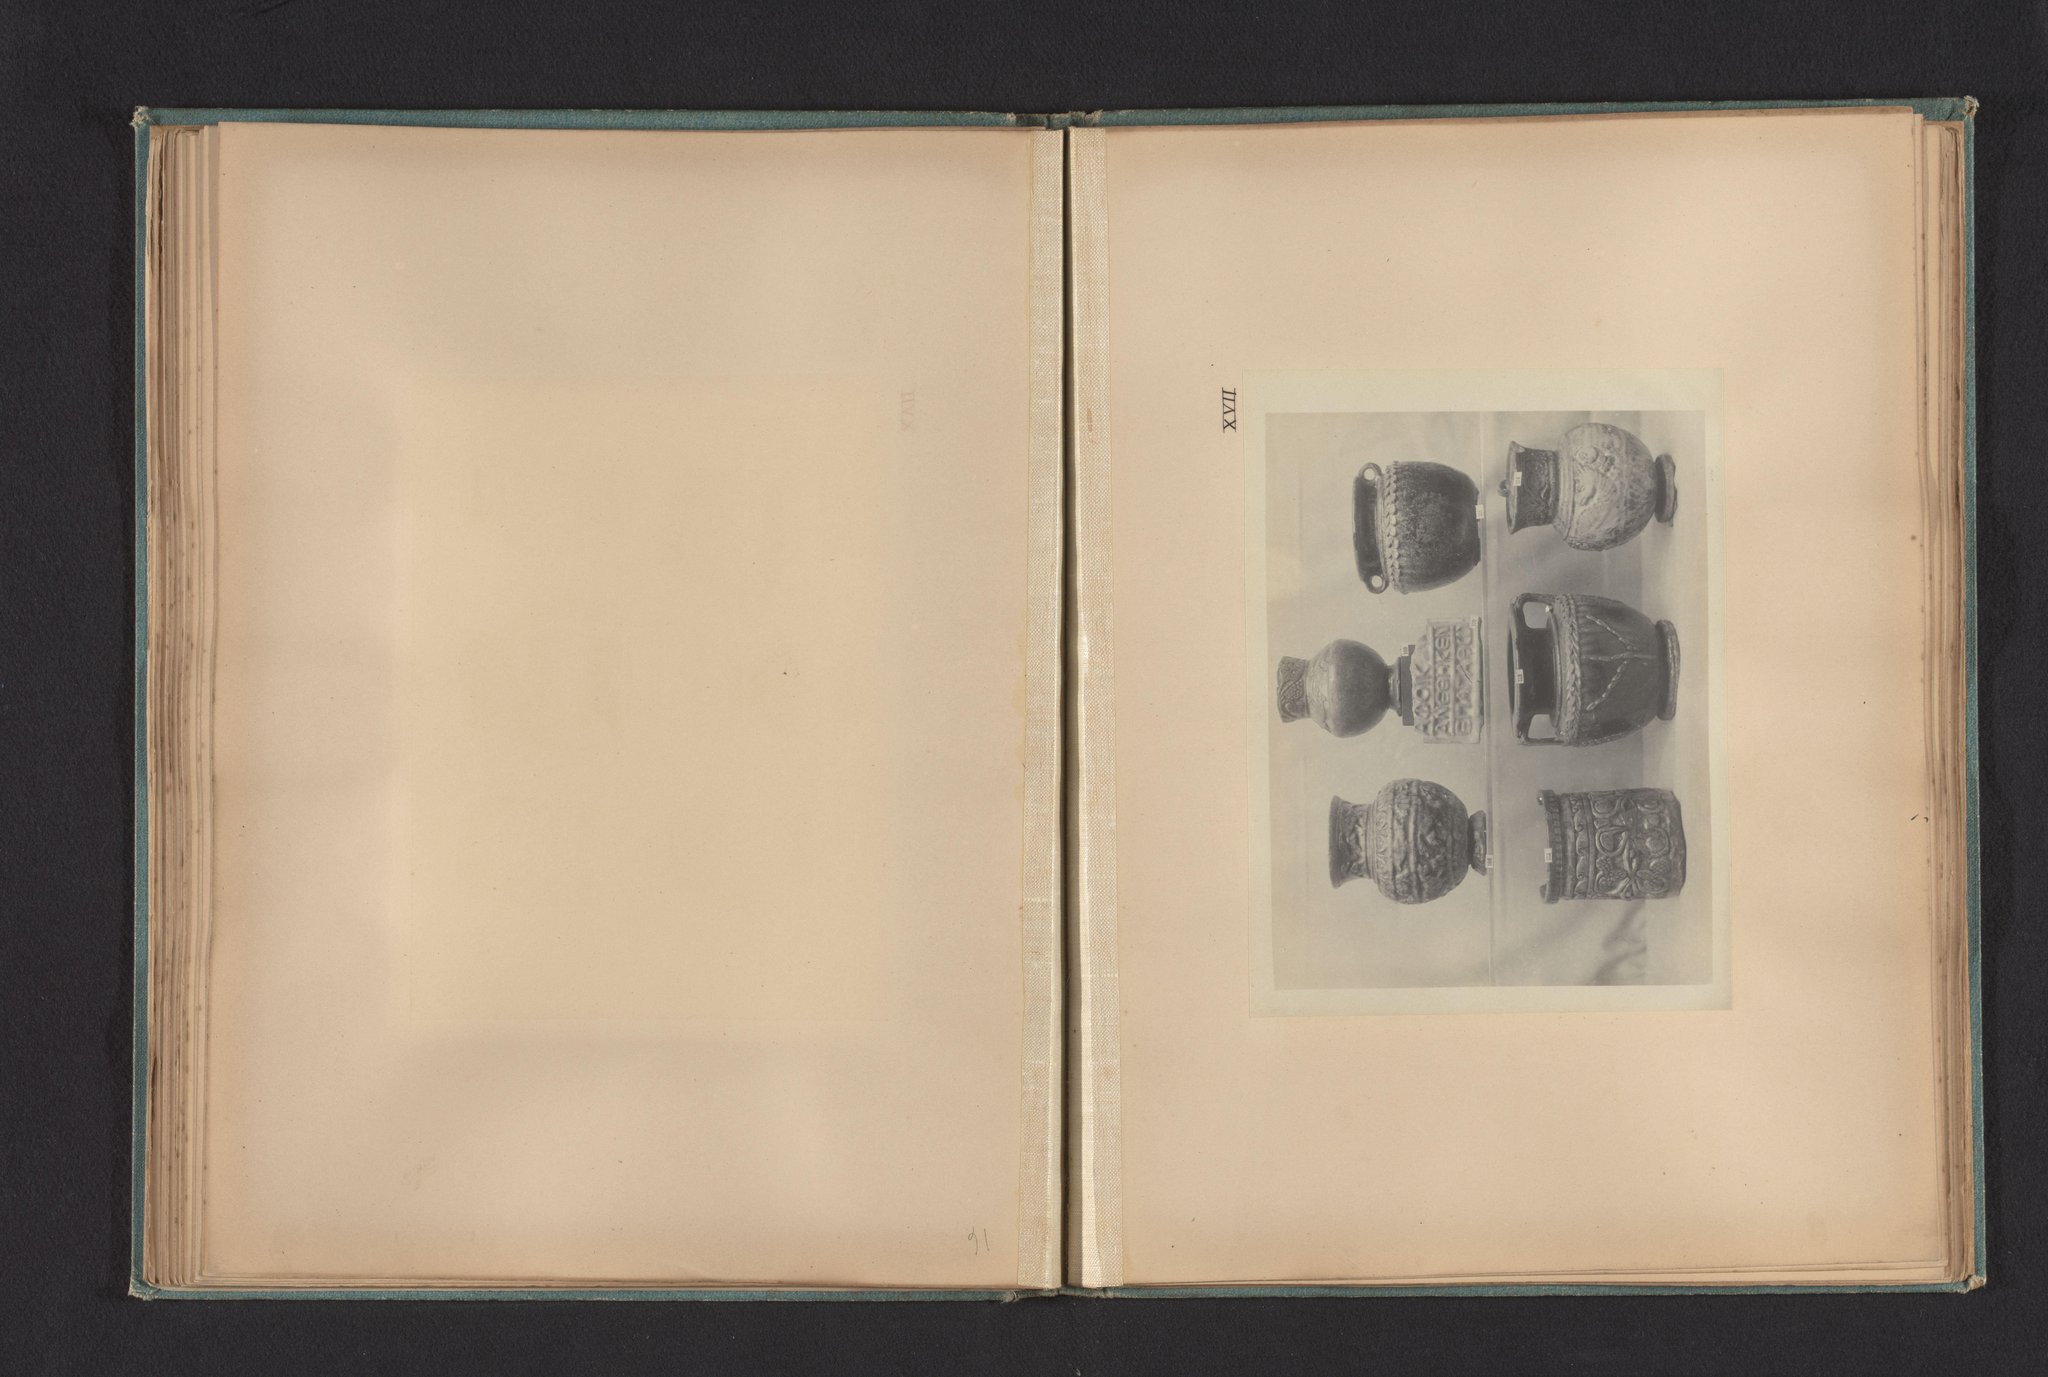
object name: page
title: Zes Egyptische vazen en één stenen fragment met tekst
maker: Anonymous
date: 1890-1895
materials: photographic support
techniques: gelatin silver print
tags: containers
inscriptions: number: ‘XVII’